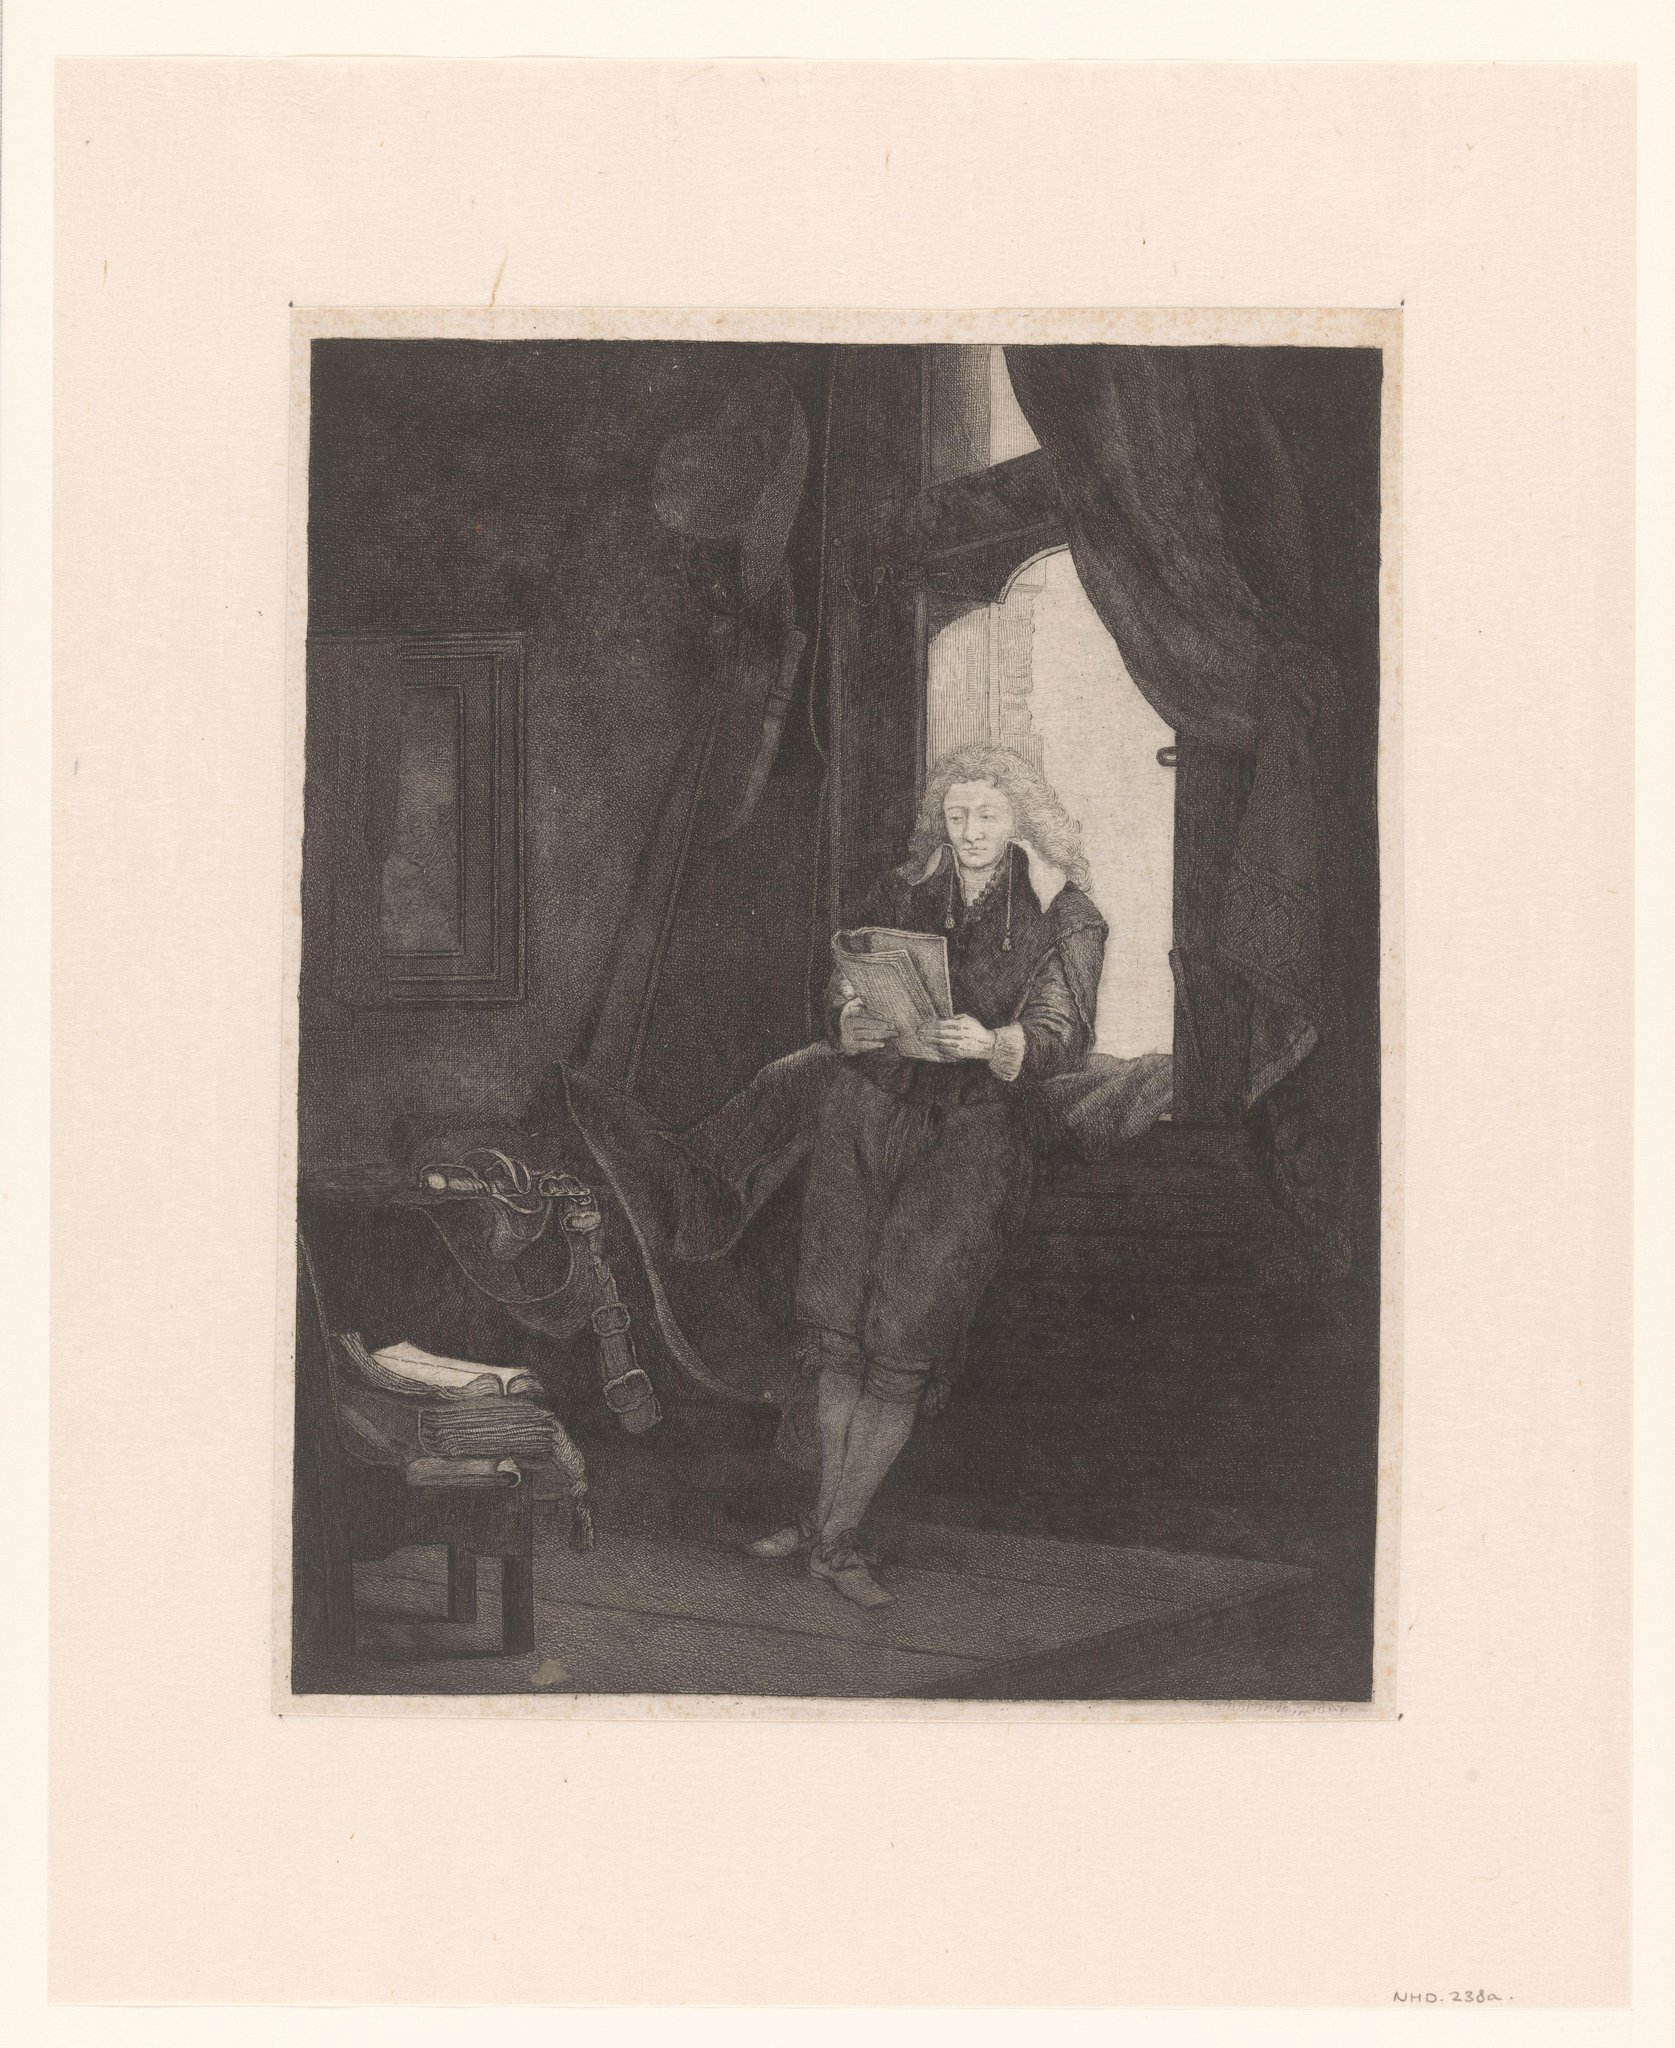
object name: print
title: Jan Six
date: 1733-1797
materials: paper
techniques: etching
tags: mayor, jan six (1618-1700), historical persons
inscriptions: collector's mark: Lugt 2228, collector's mark: Lugt 2760